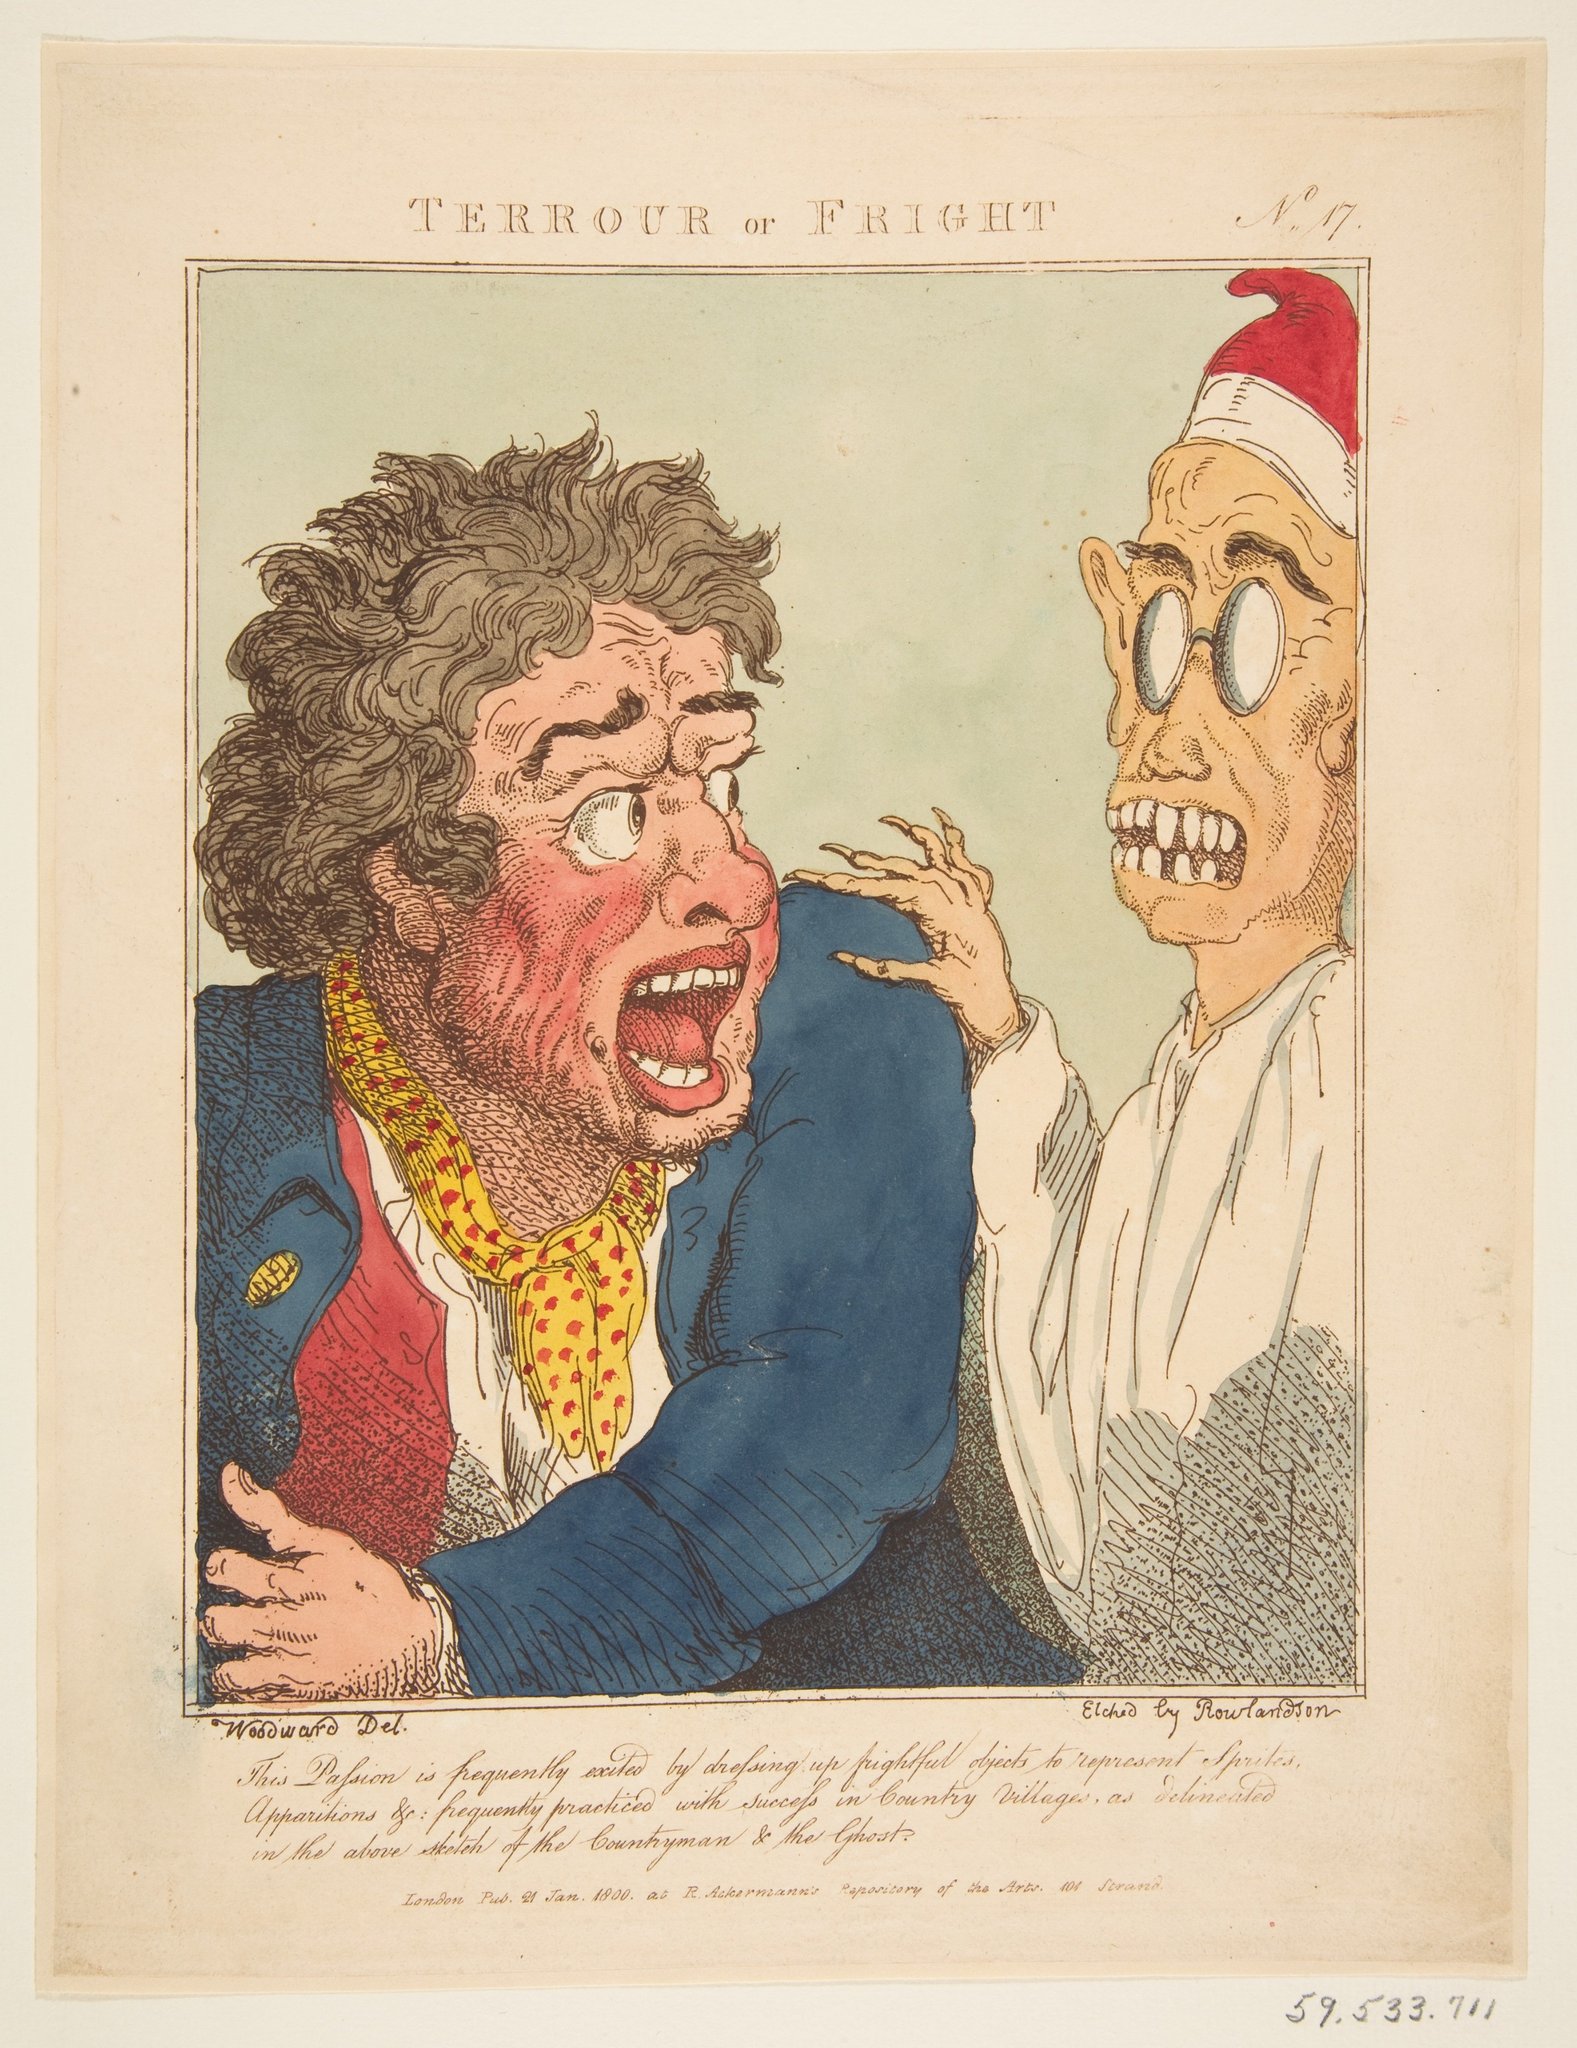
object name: print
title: Terrour or Fright (Le Brun Travested, or Caricatures of the Passions)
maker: thomas rowlandson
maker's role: artist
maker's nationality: british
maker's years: 1757-1827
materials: ink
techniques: etching, printing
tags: satire,fear,men